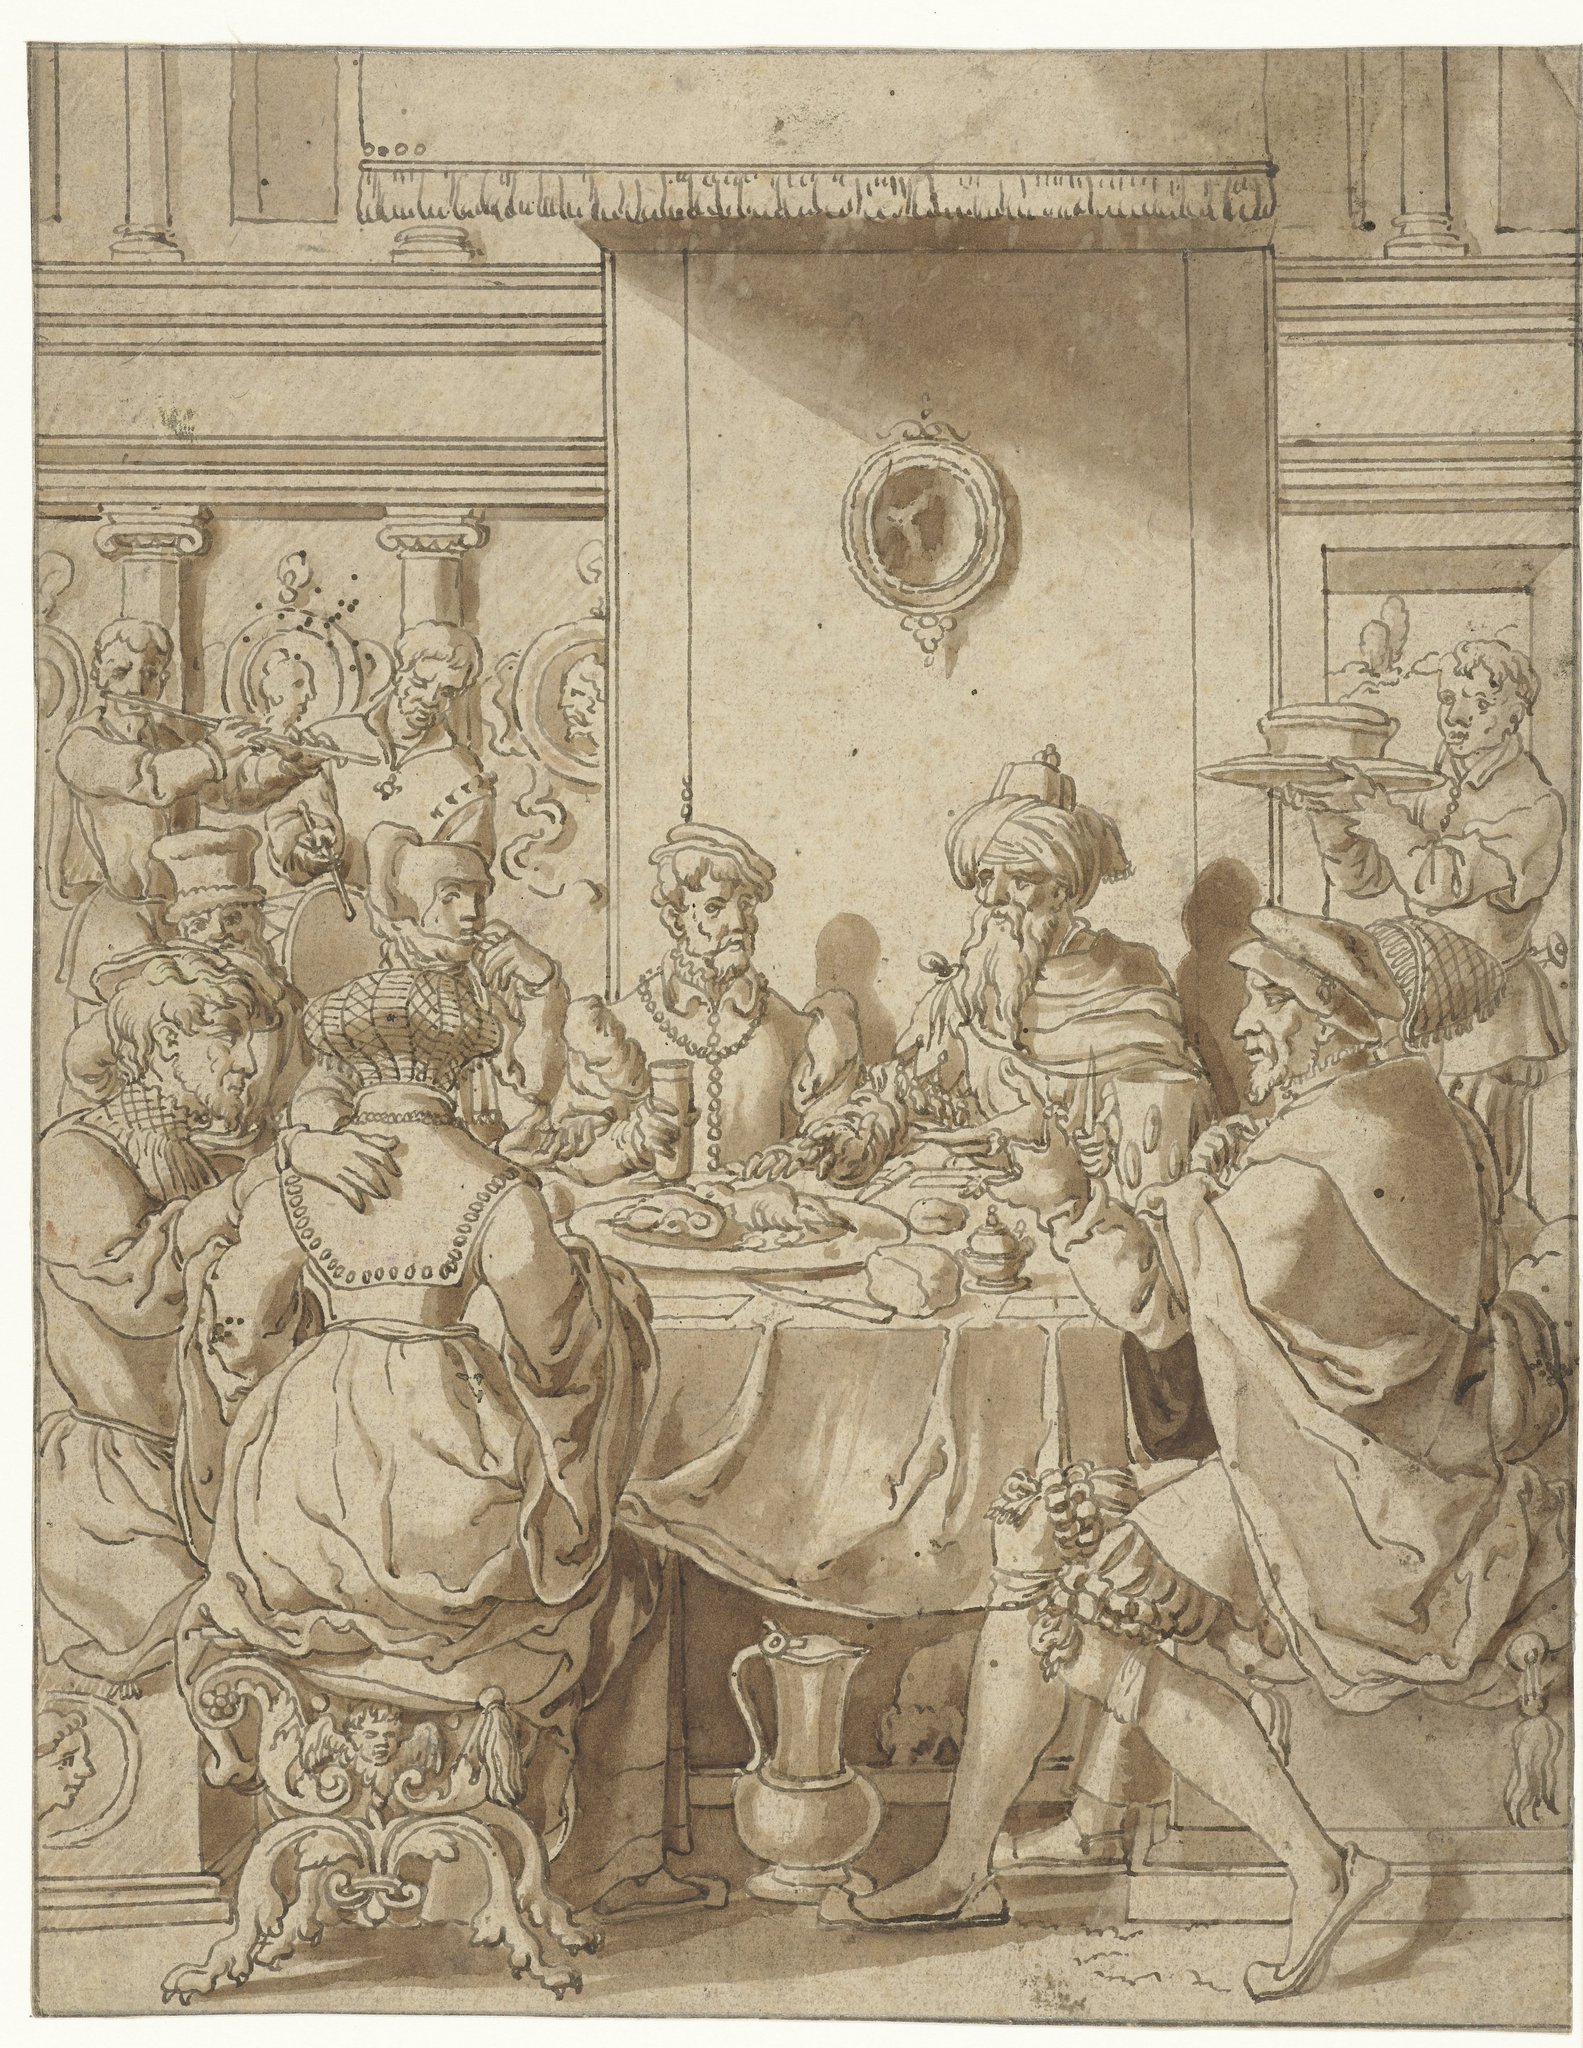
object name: drawing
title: Maaltijd van Esther en Ahasverus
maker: jan swart van groningen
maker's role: draughtsman, painter, print maker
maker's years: 1500-1562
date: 1530-1540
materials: ink, paper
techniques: brush, pen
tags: esther's first banquet: ahasuerus and haman are esther's guests; she invites them for a second meal, cake, tart, pastry